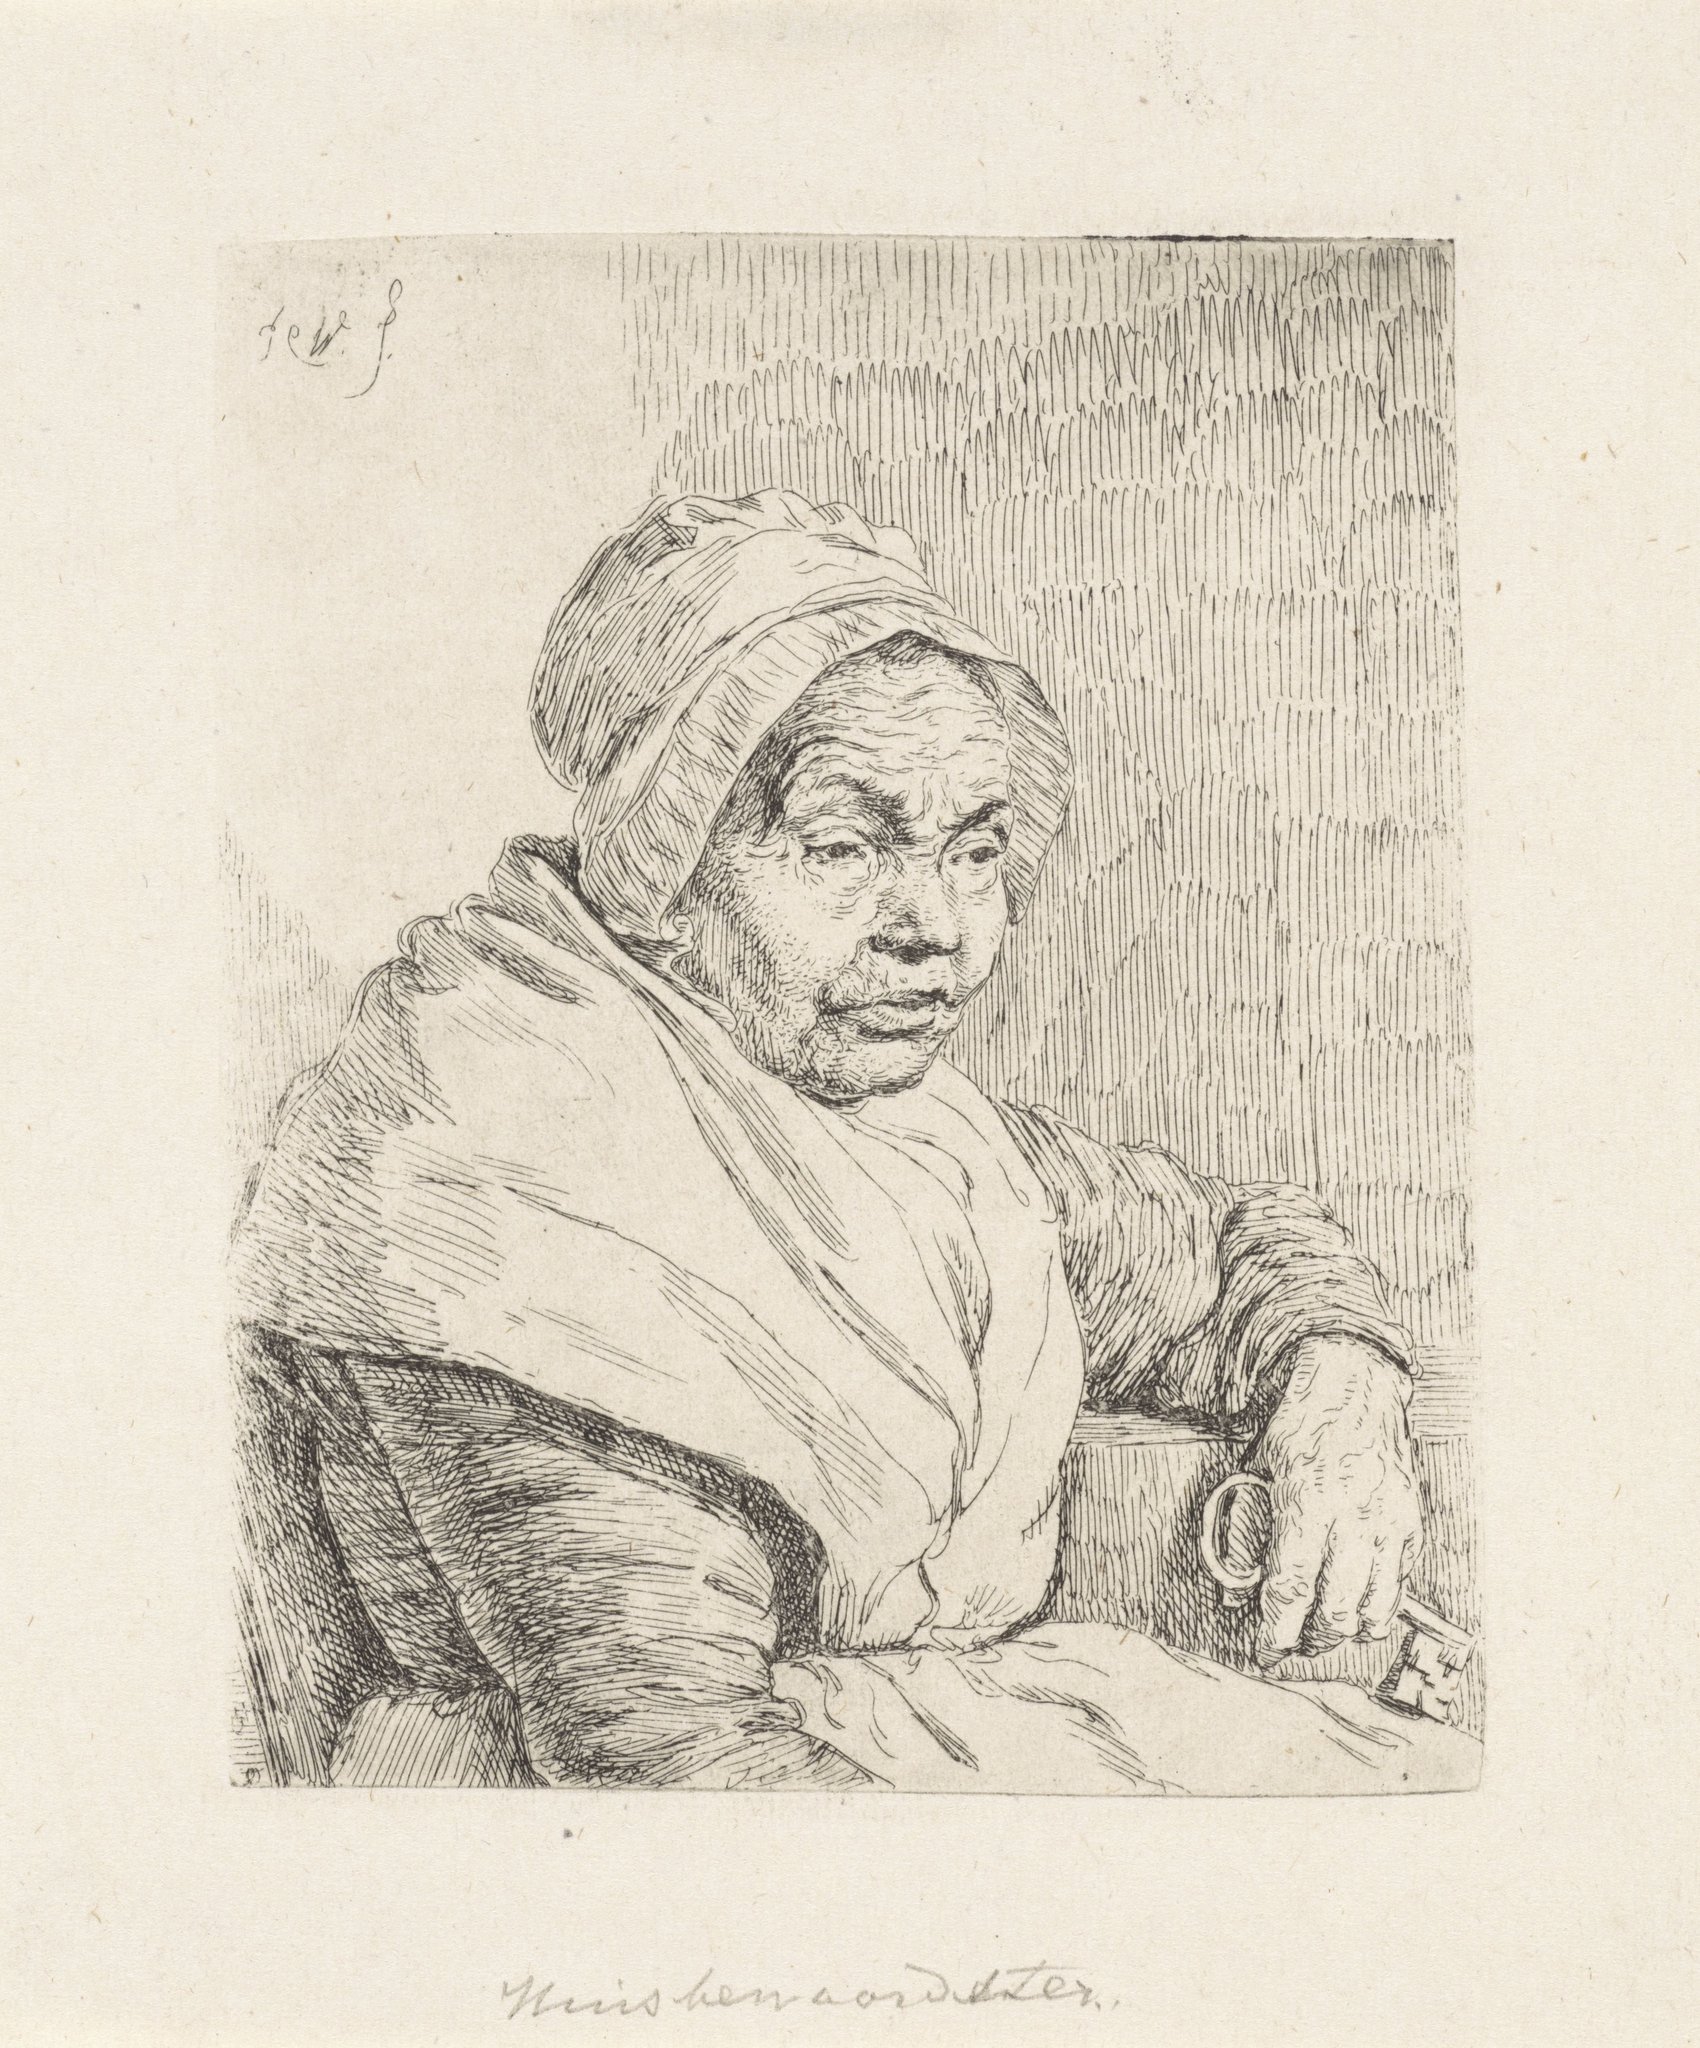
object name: print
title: Portret van een oude vrouw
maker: pieter christoffel wonder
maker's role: draughtsman, painter, print maker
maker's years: 1780-1852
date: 1802-1816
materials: paper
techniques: etching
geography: utrecht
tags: historical persons, key, old woman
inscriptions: collector's mark: Lugt 2228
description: Portret van een zittende oude vrouw. Ze draagt een muts en houdt een sleutel in haar hand. De vrouw was de beheerster van het huis van Van Amerongen in de Utrechtse Wittevrouwenstraat, waar de kunstenaar een bovenverdieping huurde.